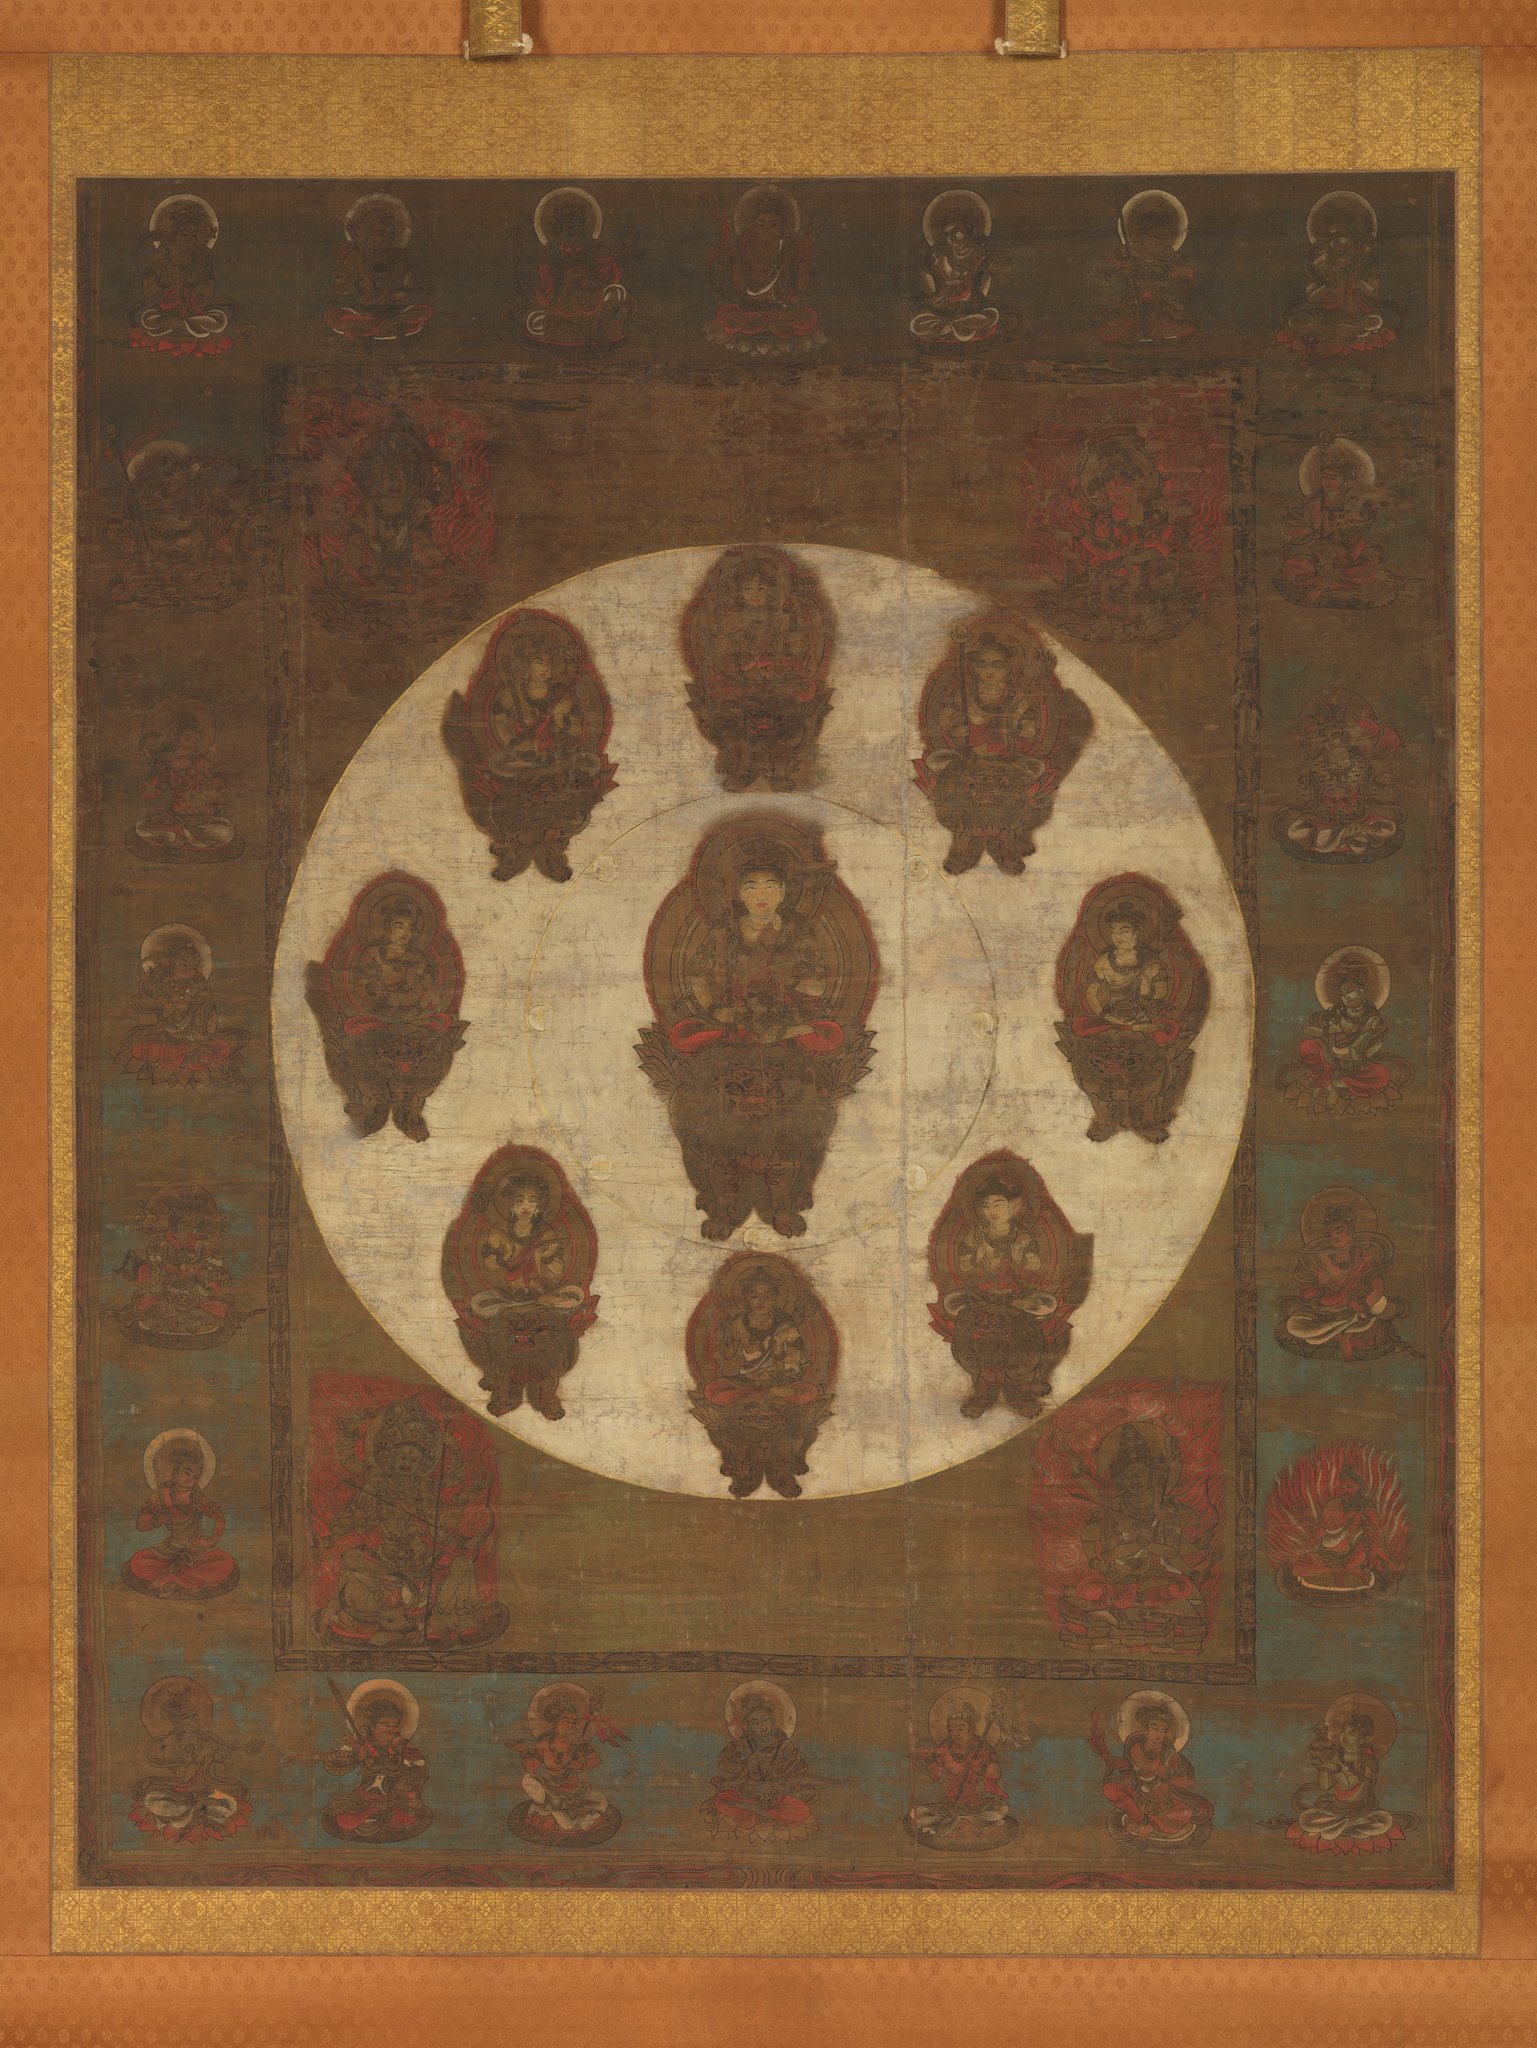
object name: hanging scroll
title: Mandala of the Bodhisattva Monju (Manjushri) of the Eight Syllables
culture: japanese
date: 1201-1300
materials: gold, gold leaf, ink, silk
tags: buddhism,bodhisattvas,buddha,manjushri